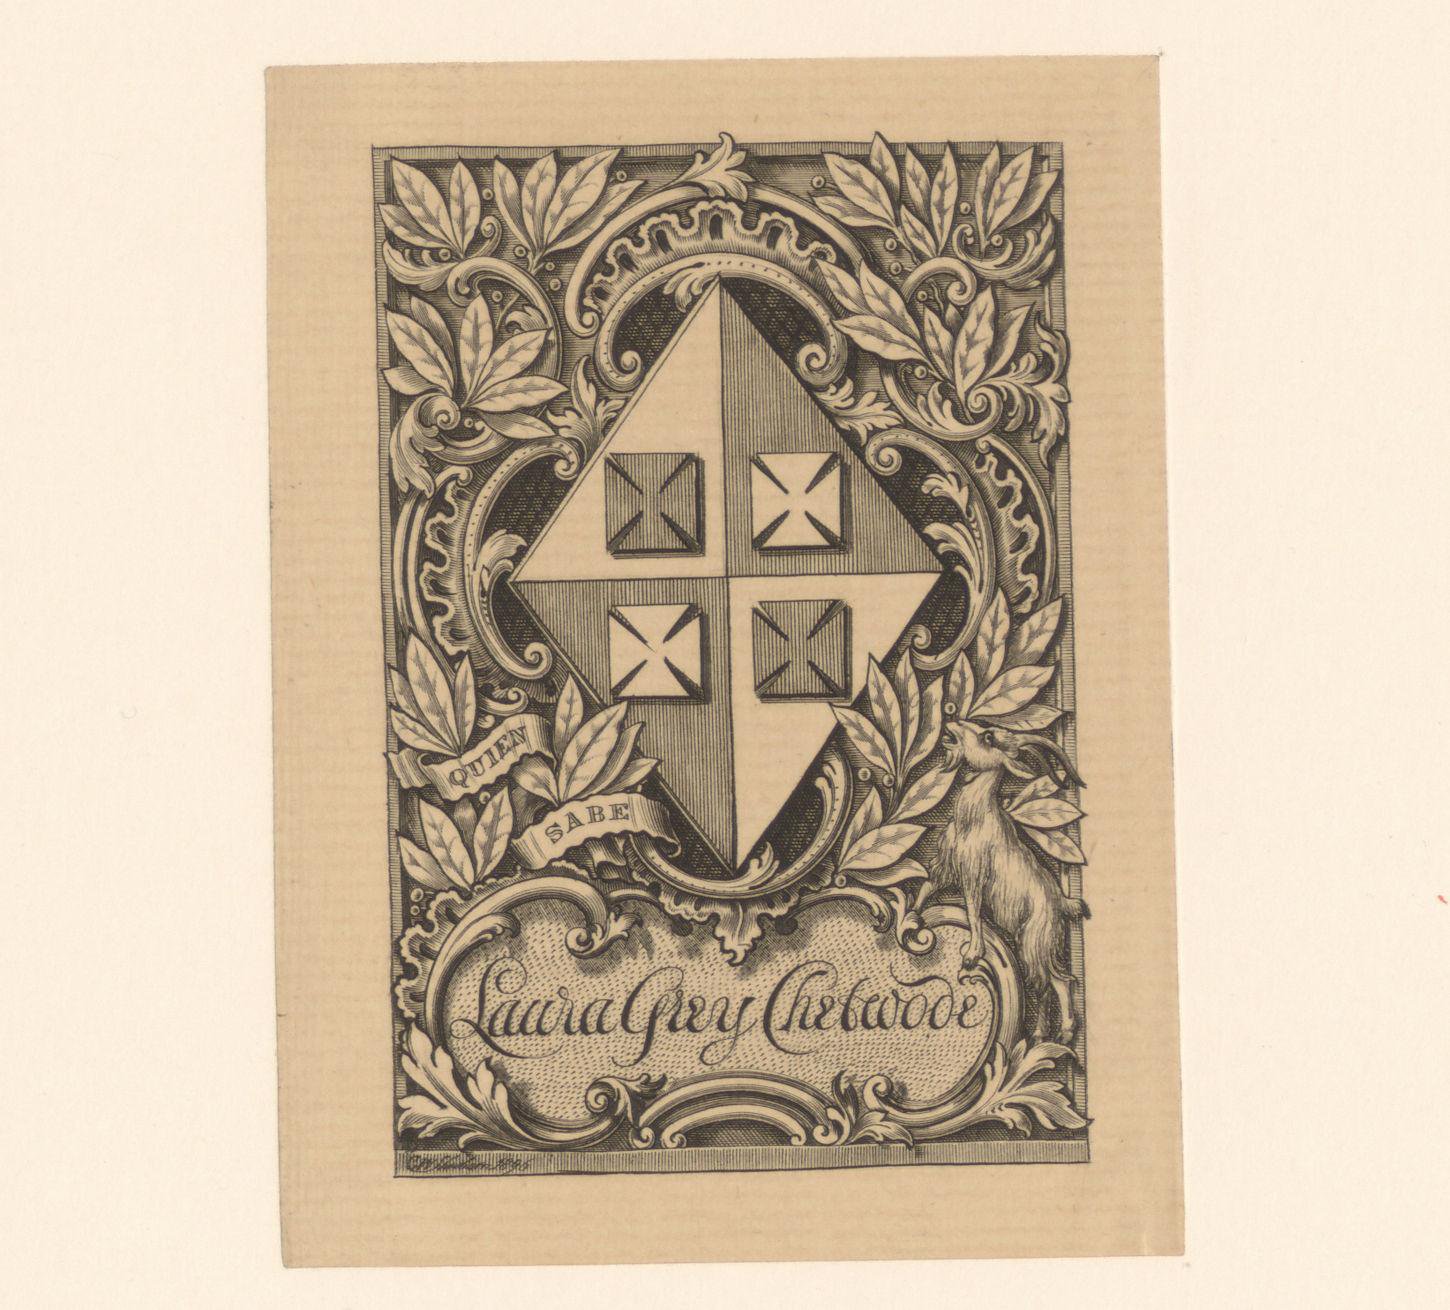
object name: bookplate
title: Ex libris van Laura Grey Eliot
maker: charles william sherborn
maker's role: print maker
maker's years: 1831-1912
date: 1896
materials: paper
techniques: engraving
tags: foliage ~ ornament, goat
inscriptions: collector's mark: Lugt 2228